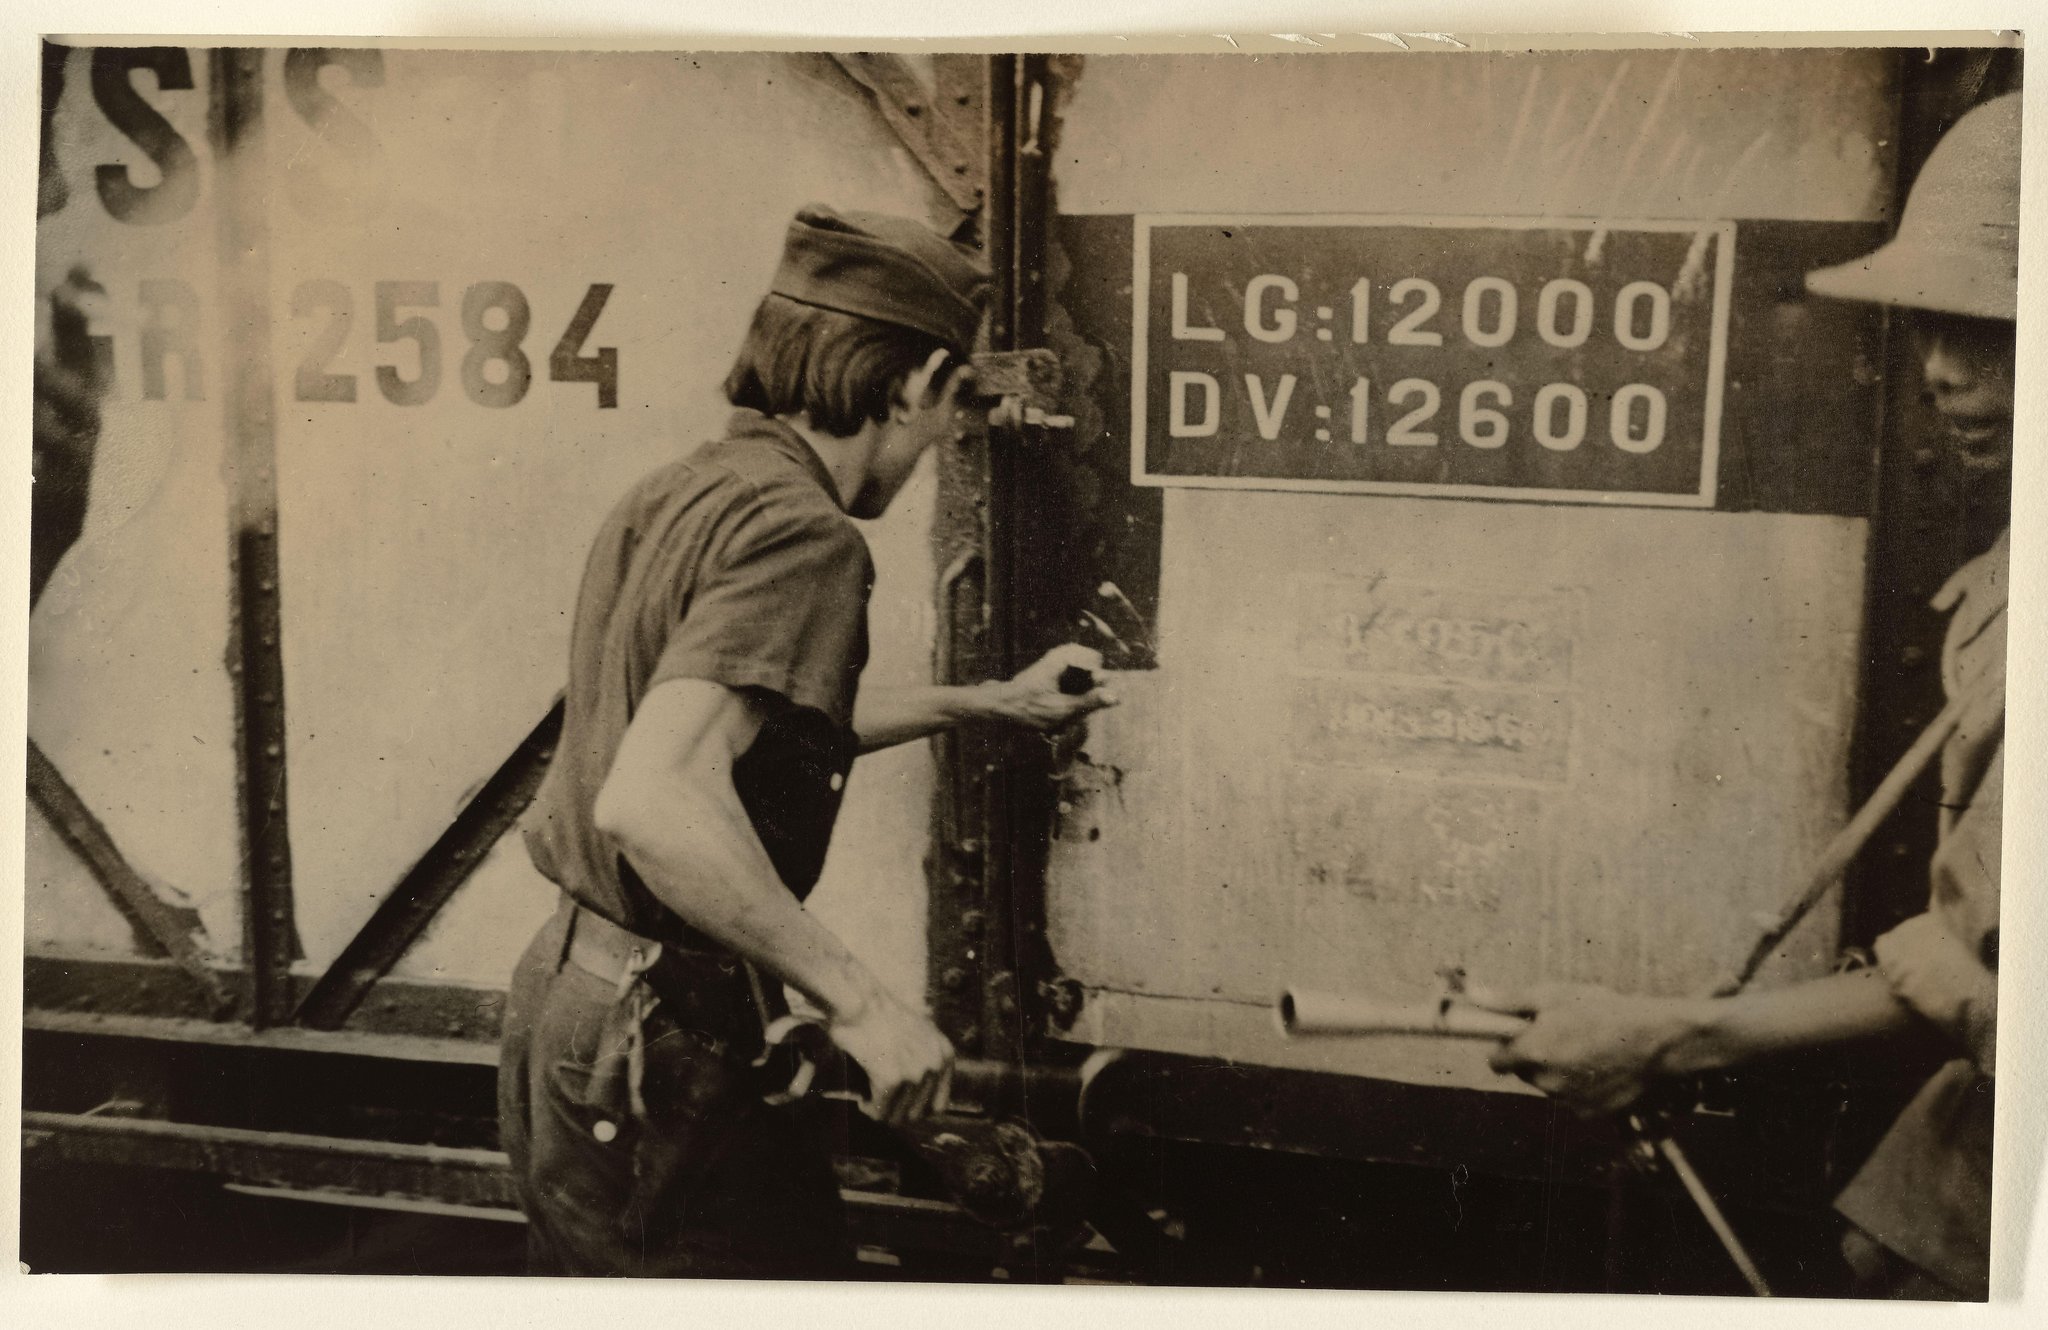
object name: documentary photograph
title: Republikeinse soldaat breekt een wagon open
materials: photographic support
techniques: photography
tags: indonesia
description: Republikeinse soldaat breekt een wagon open met rechts van hem een tweede guerillastrijder.